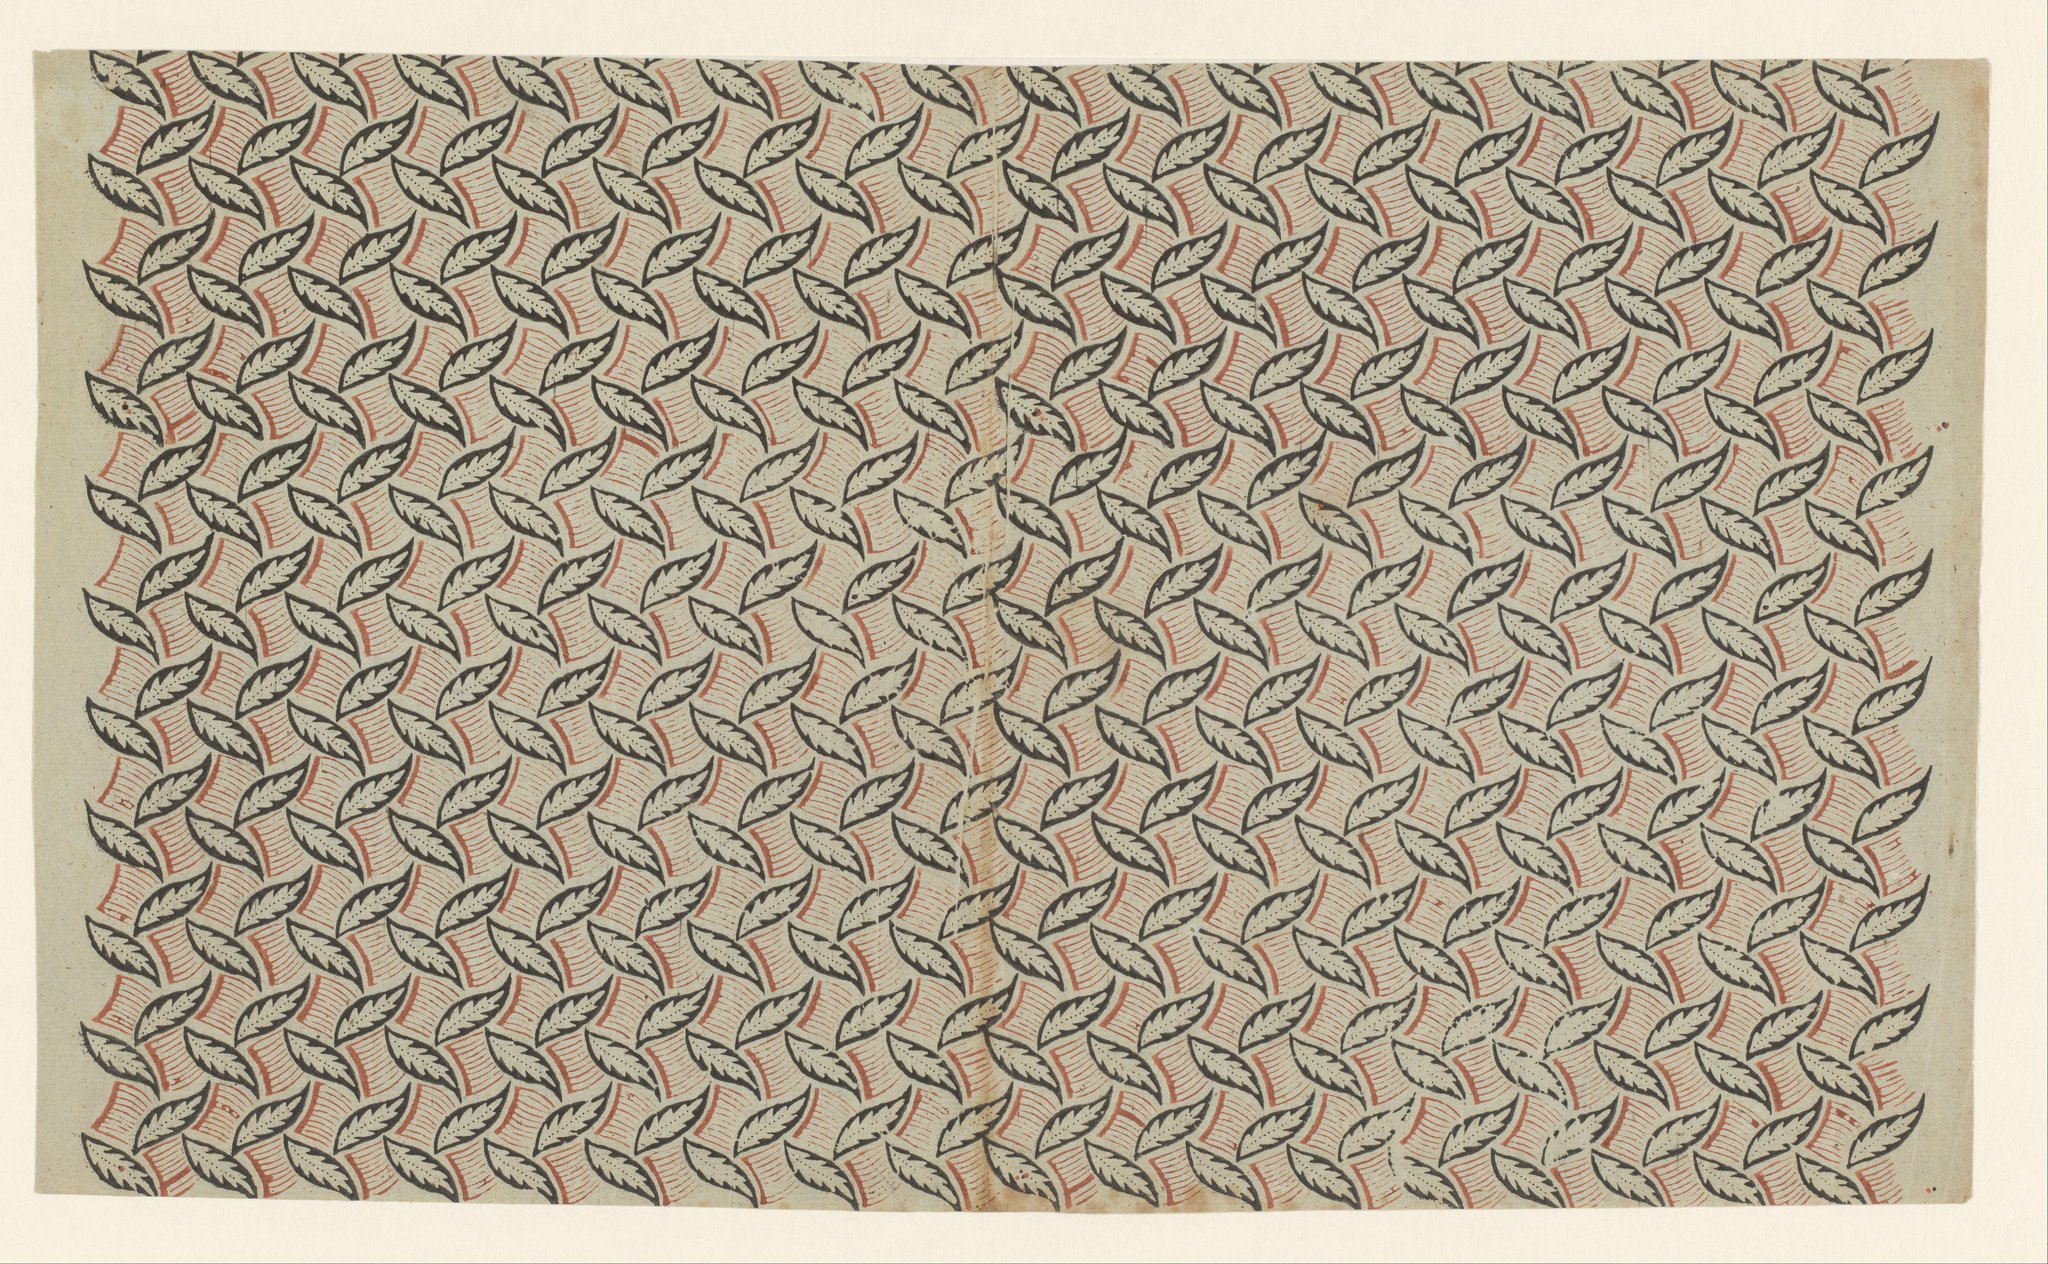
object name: wrapper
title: Blad met alternerend strooipatroon van blad en streepjesblok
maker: Anonymous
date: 1700-1850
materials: lacquer, paper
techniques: printing block, lacquer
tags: ornament derived from plant forms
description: Blad met alternerend strooipatroon van blad en kamachtig streepjesblok. Gebruikt als omslag.